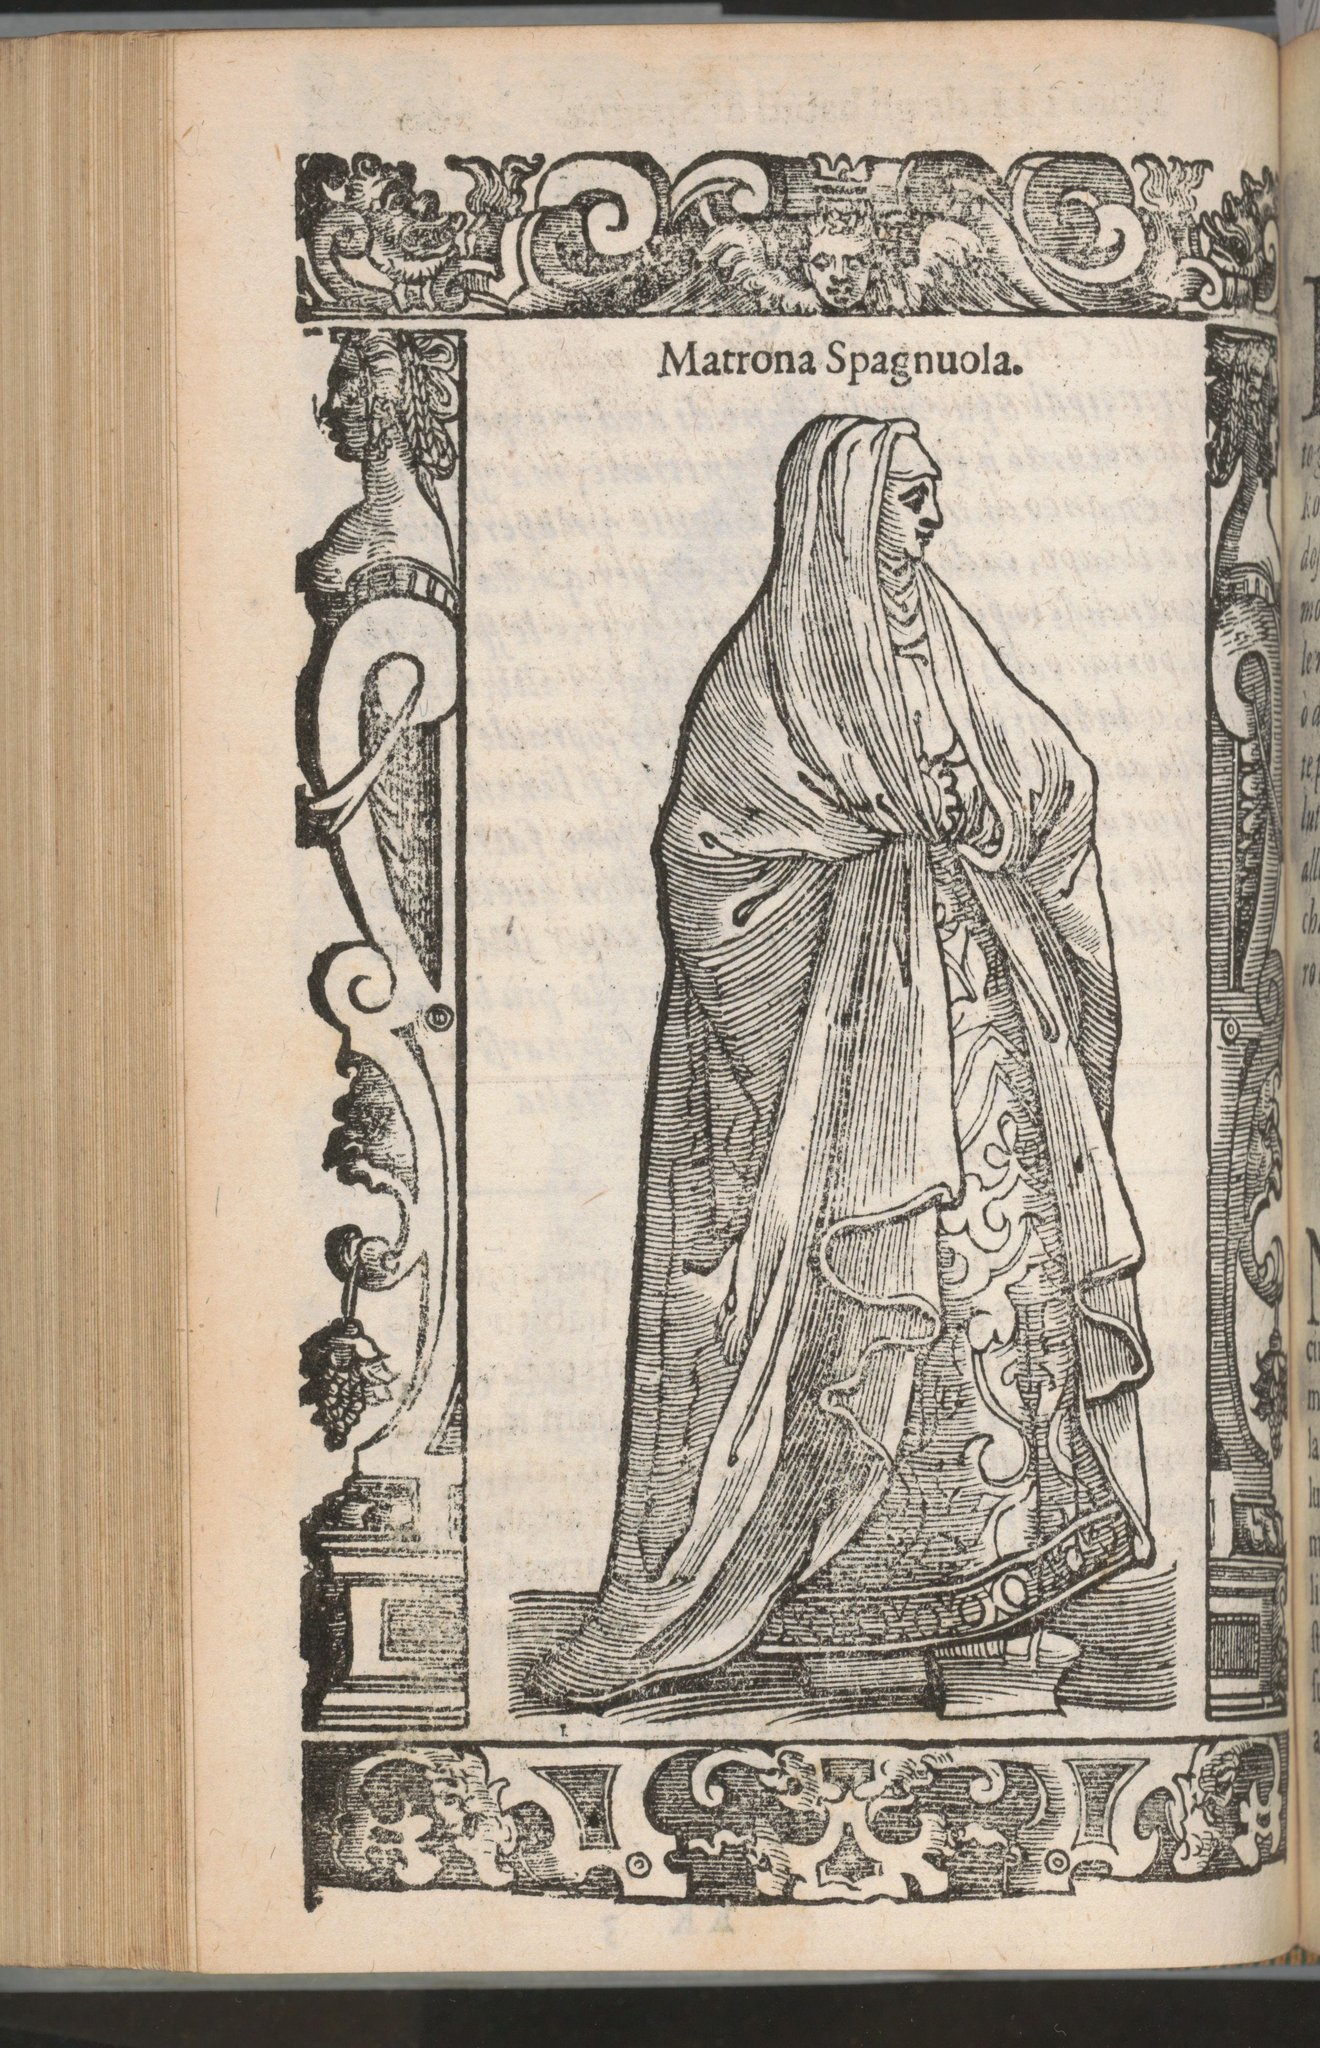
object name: costume print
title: Matrona Spagnuola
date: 1598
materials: paper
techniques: woodcut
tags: fashion plates